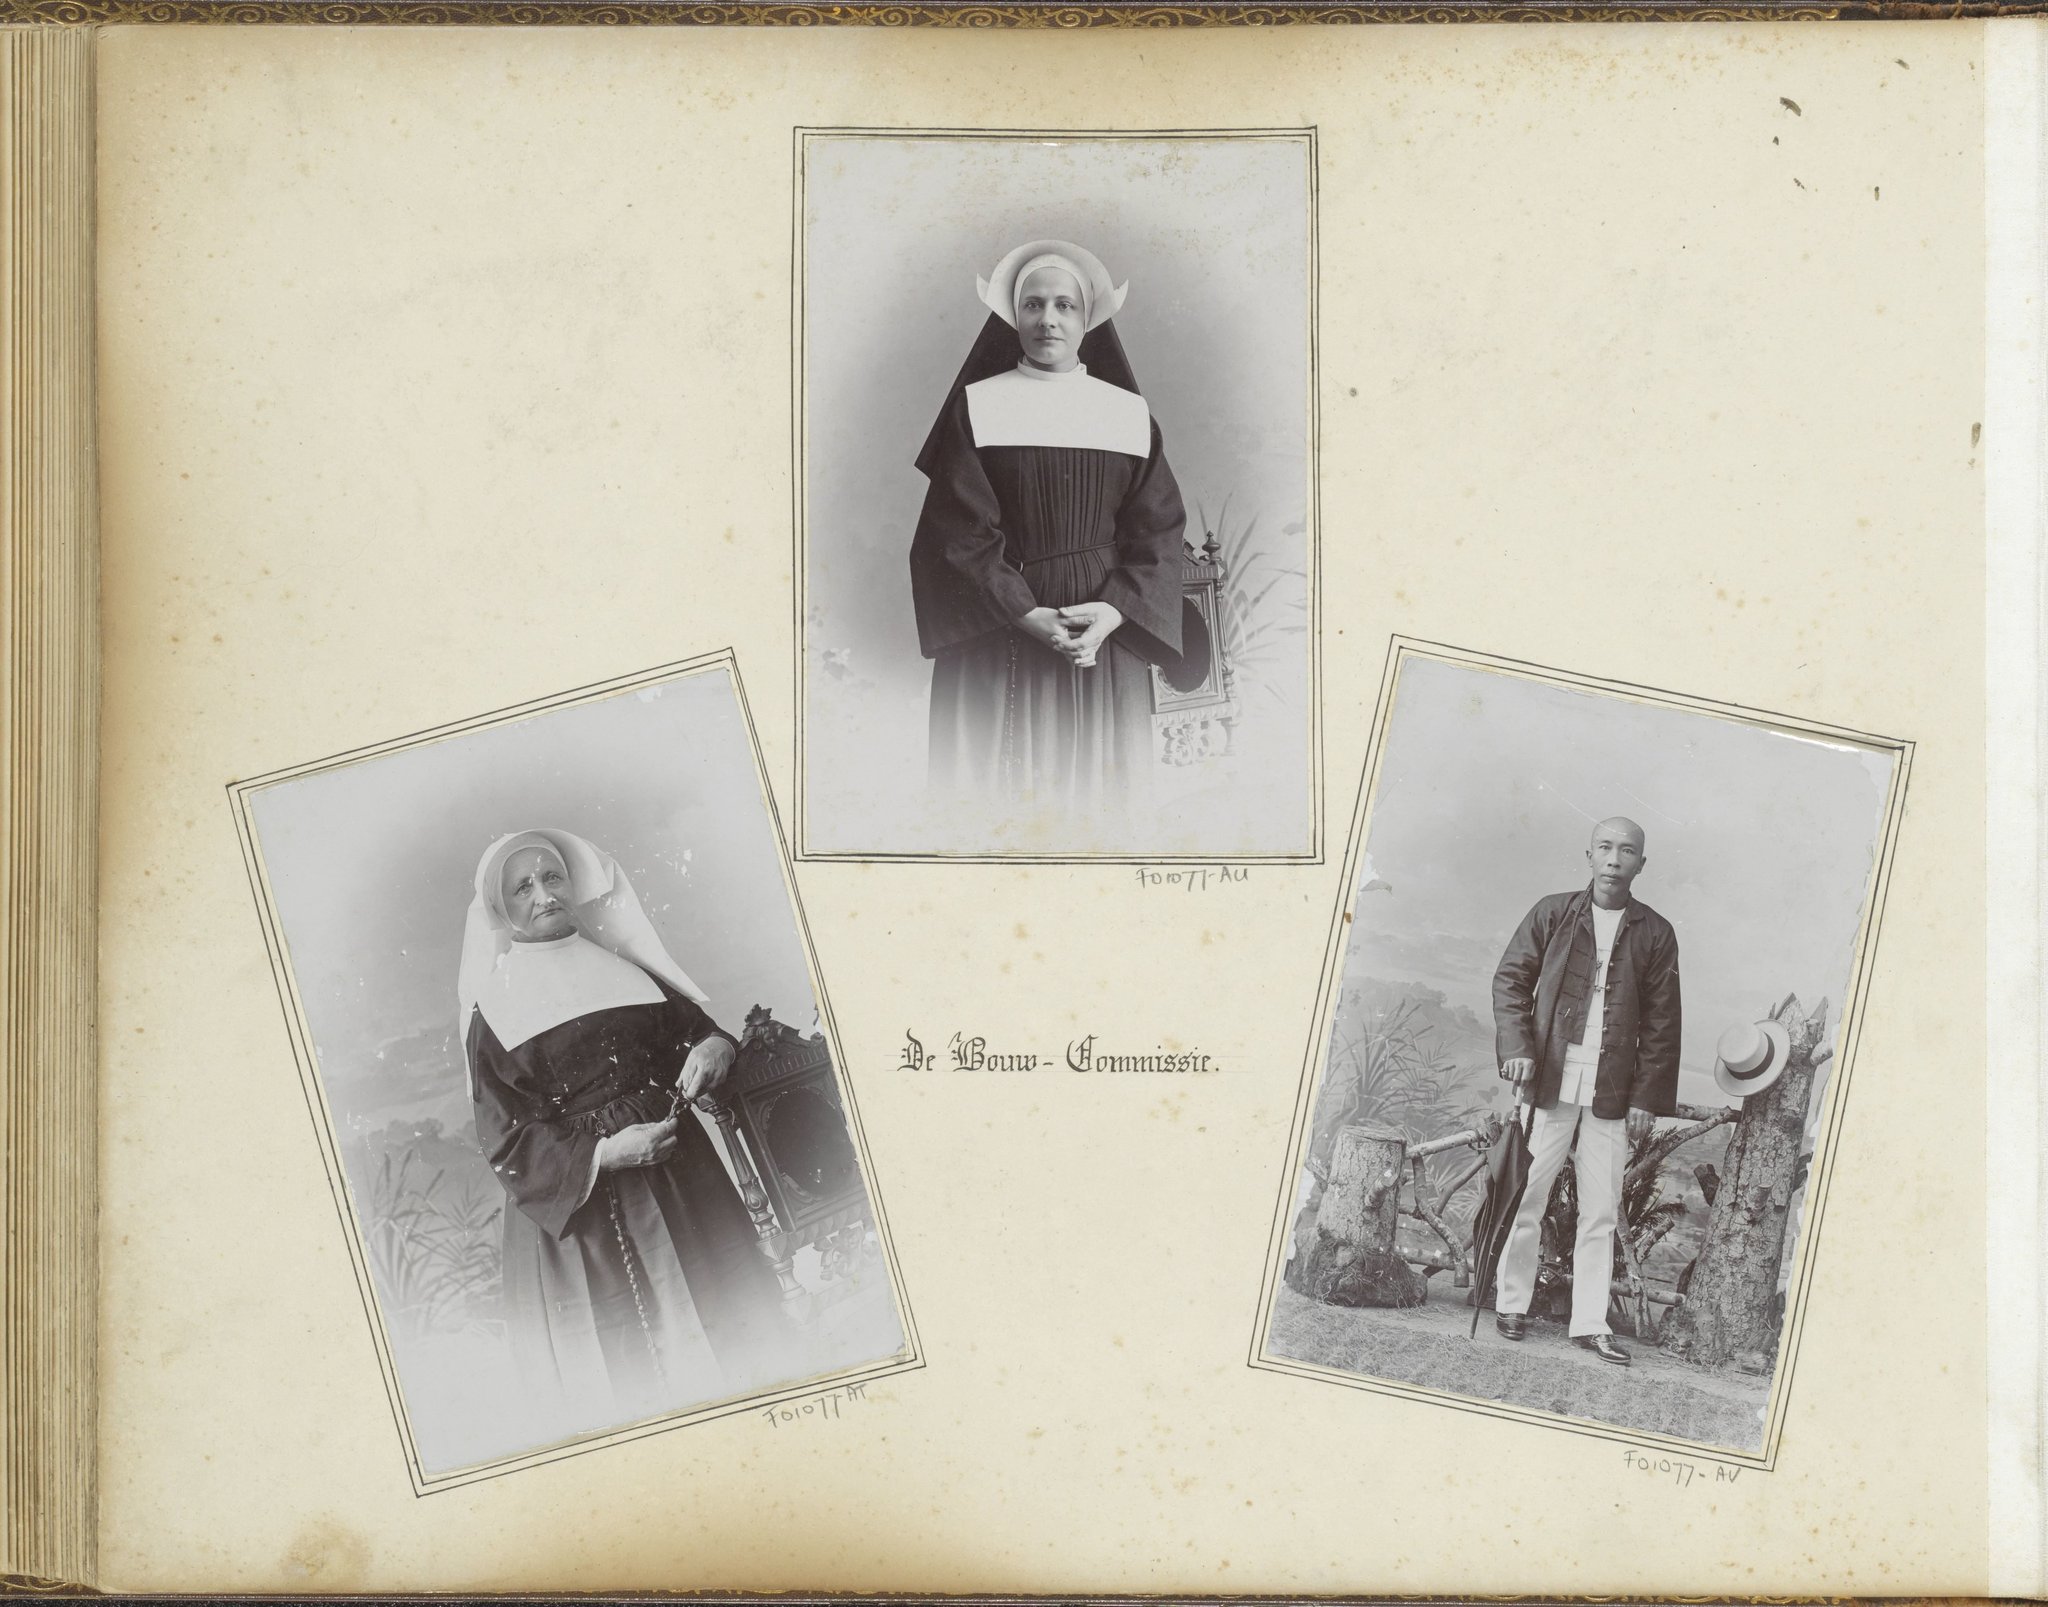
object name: photograph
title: Portret van een Javaanse man, lid van een bouwcommissie in Batavia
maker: Anonymous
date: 1890-1910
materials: cardboard, photographic support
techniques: collodion silver print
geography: batavia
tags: studio requisites ~ photographer, adult man, batavia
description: Onderdeel van Album met foto's van Batavia en van de zusters Ursulinen.